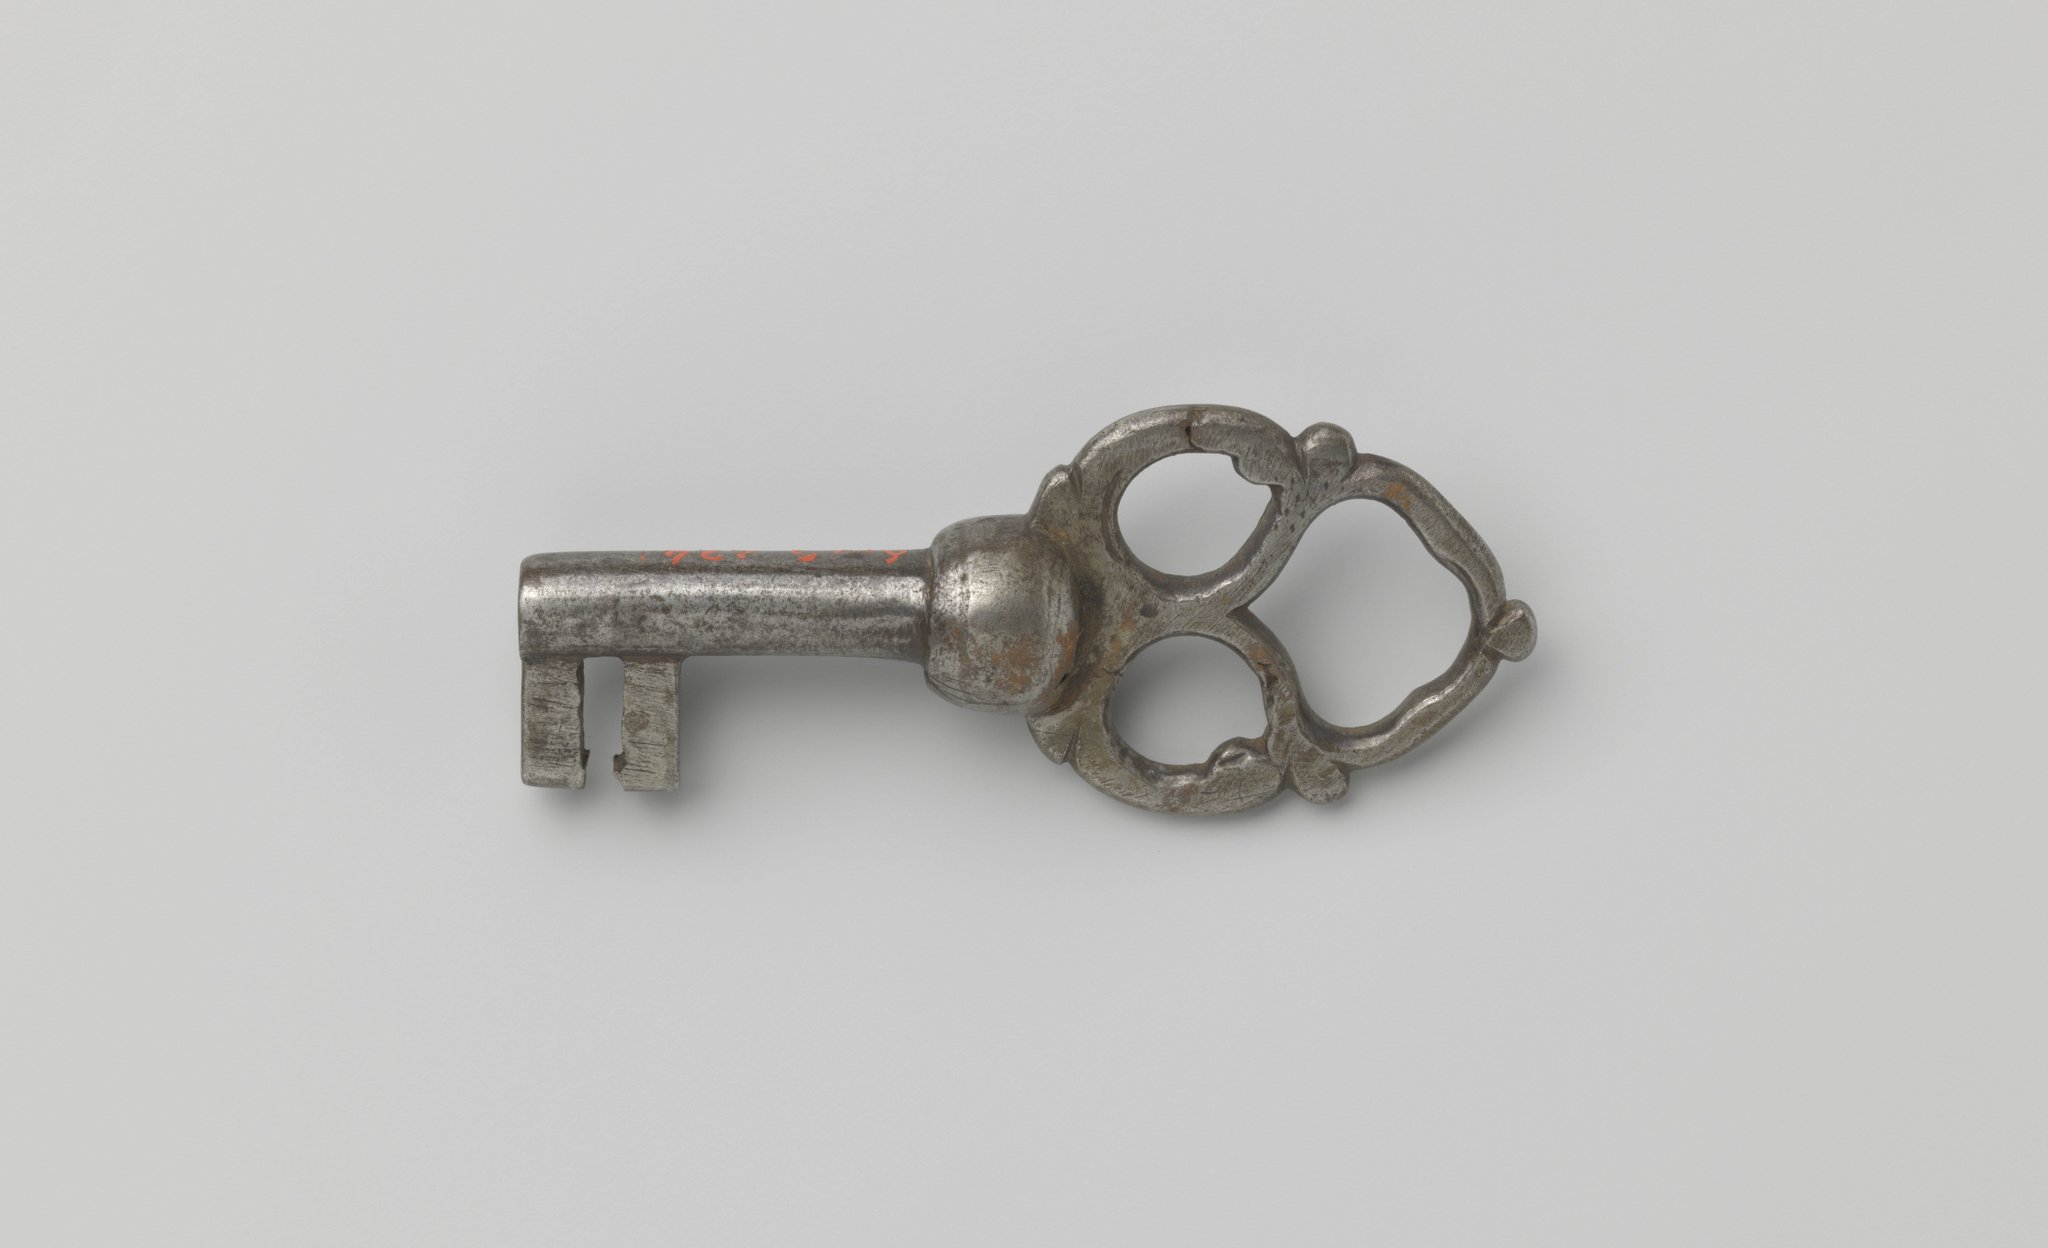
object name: pipe key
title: Pijpsleutel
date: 1700-1800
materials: iron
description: Pijpsleutel met greep door bladranken in drie openingen verdeeld. Het kapiteel is kogelvormig. Baard tweeledig.